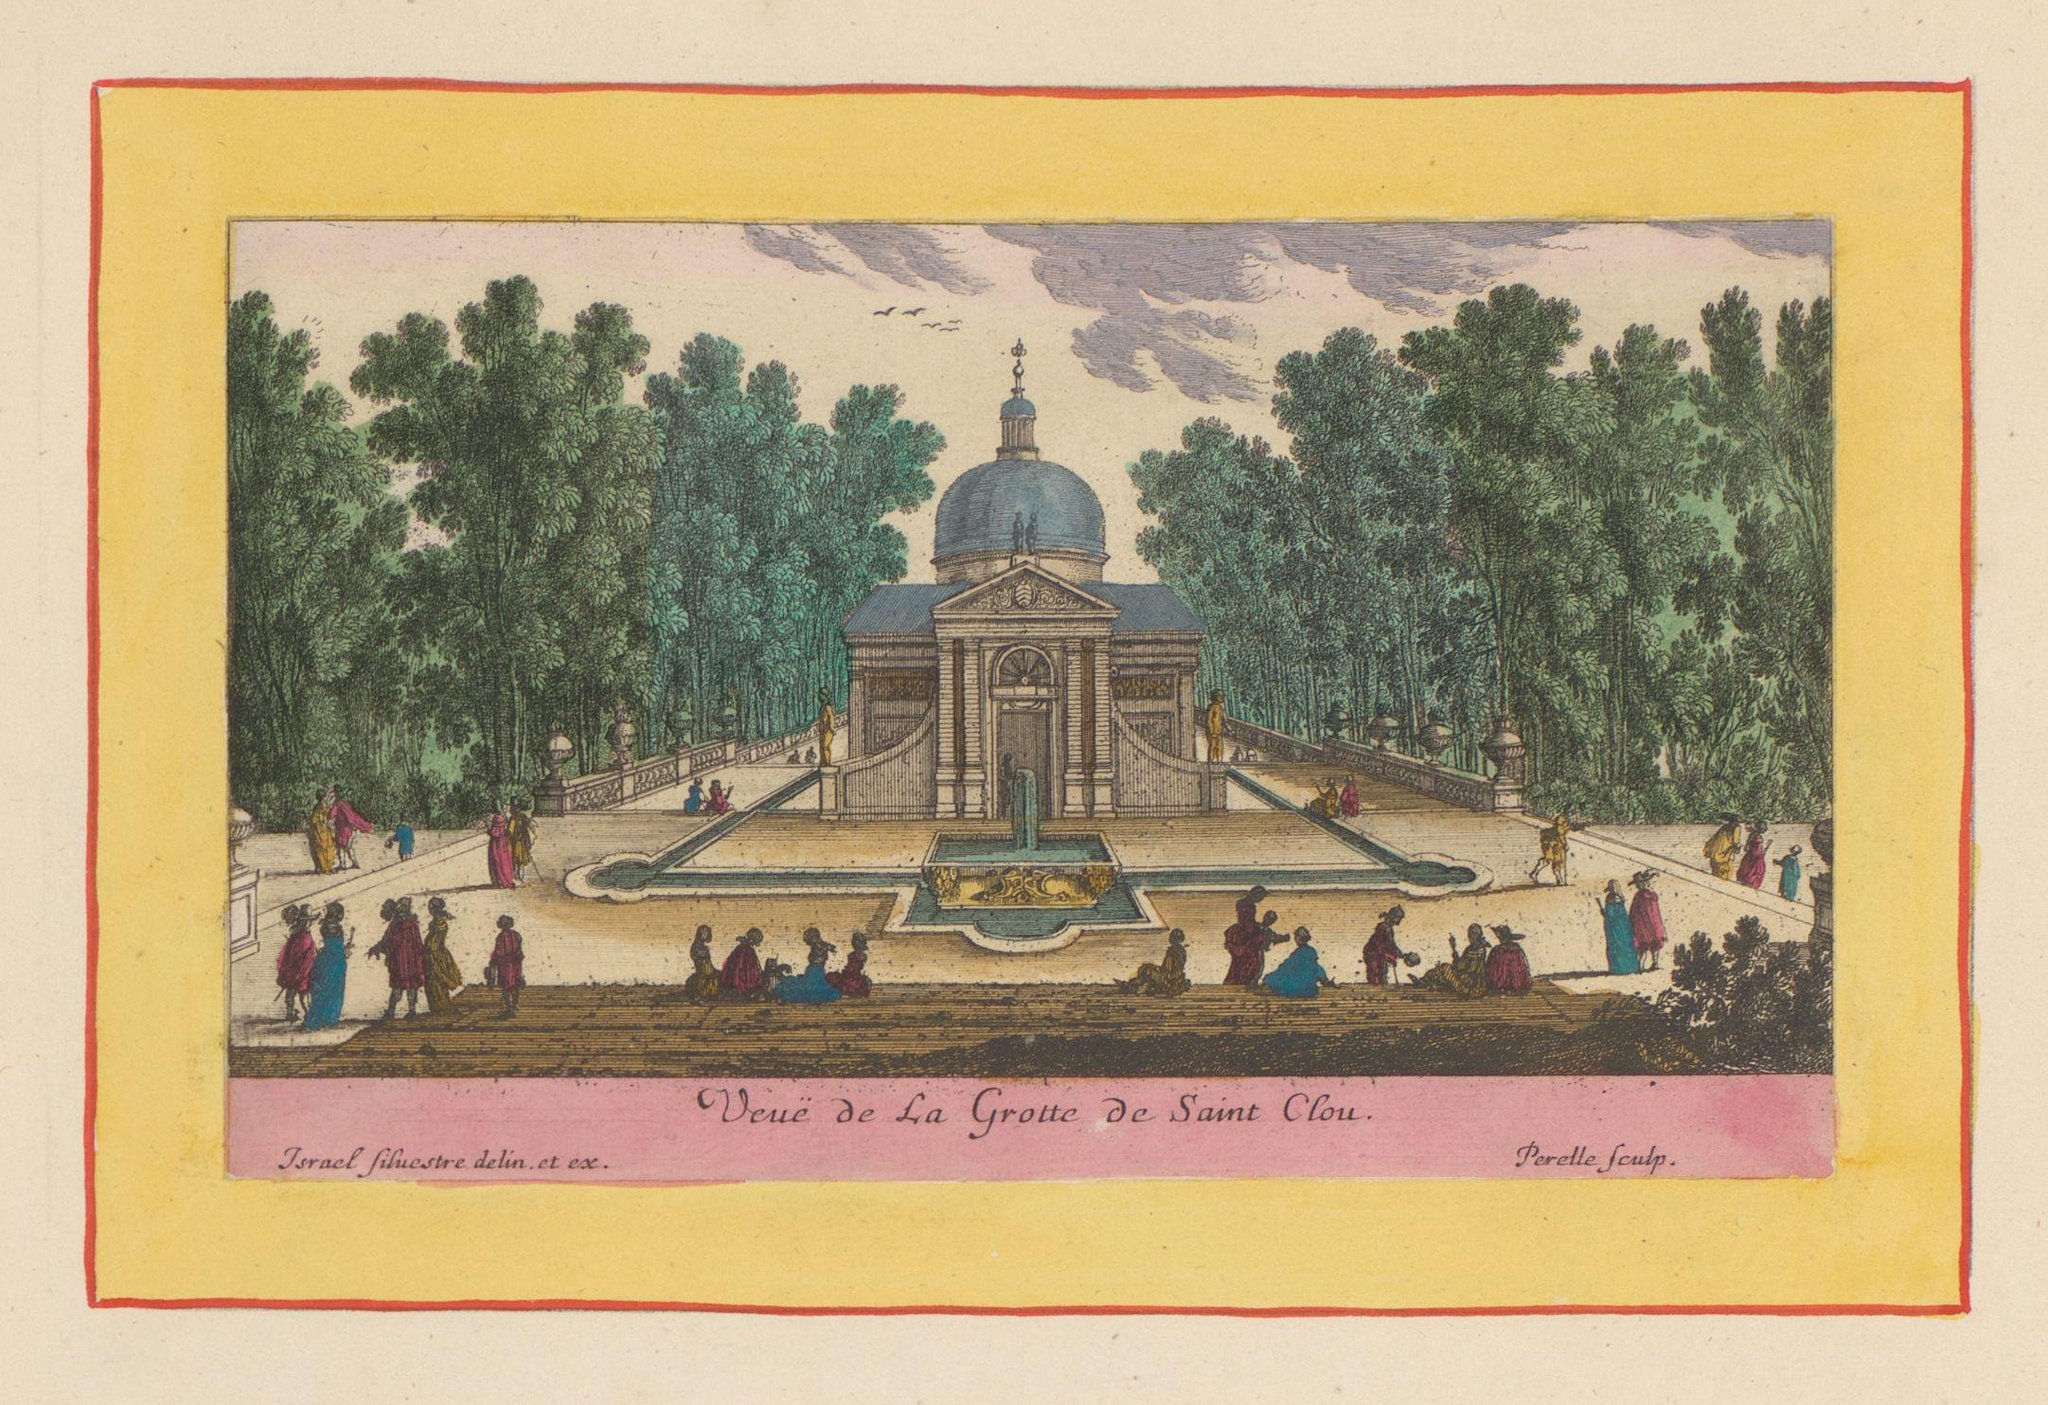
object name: print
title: Gezicht op de grot in de tuinen van Château de Saint-Cloud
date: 1631-1691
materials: paper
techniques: etching, hand coloring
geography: the hague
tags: french or architectonic garden; formal garden, artificial grotto in garden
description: Gezicht op de grot in de tuinen van Château de Saint-Cloud. Prent maakt deel uit van een album.